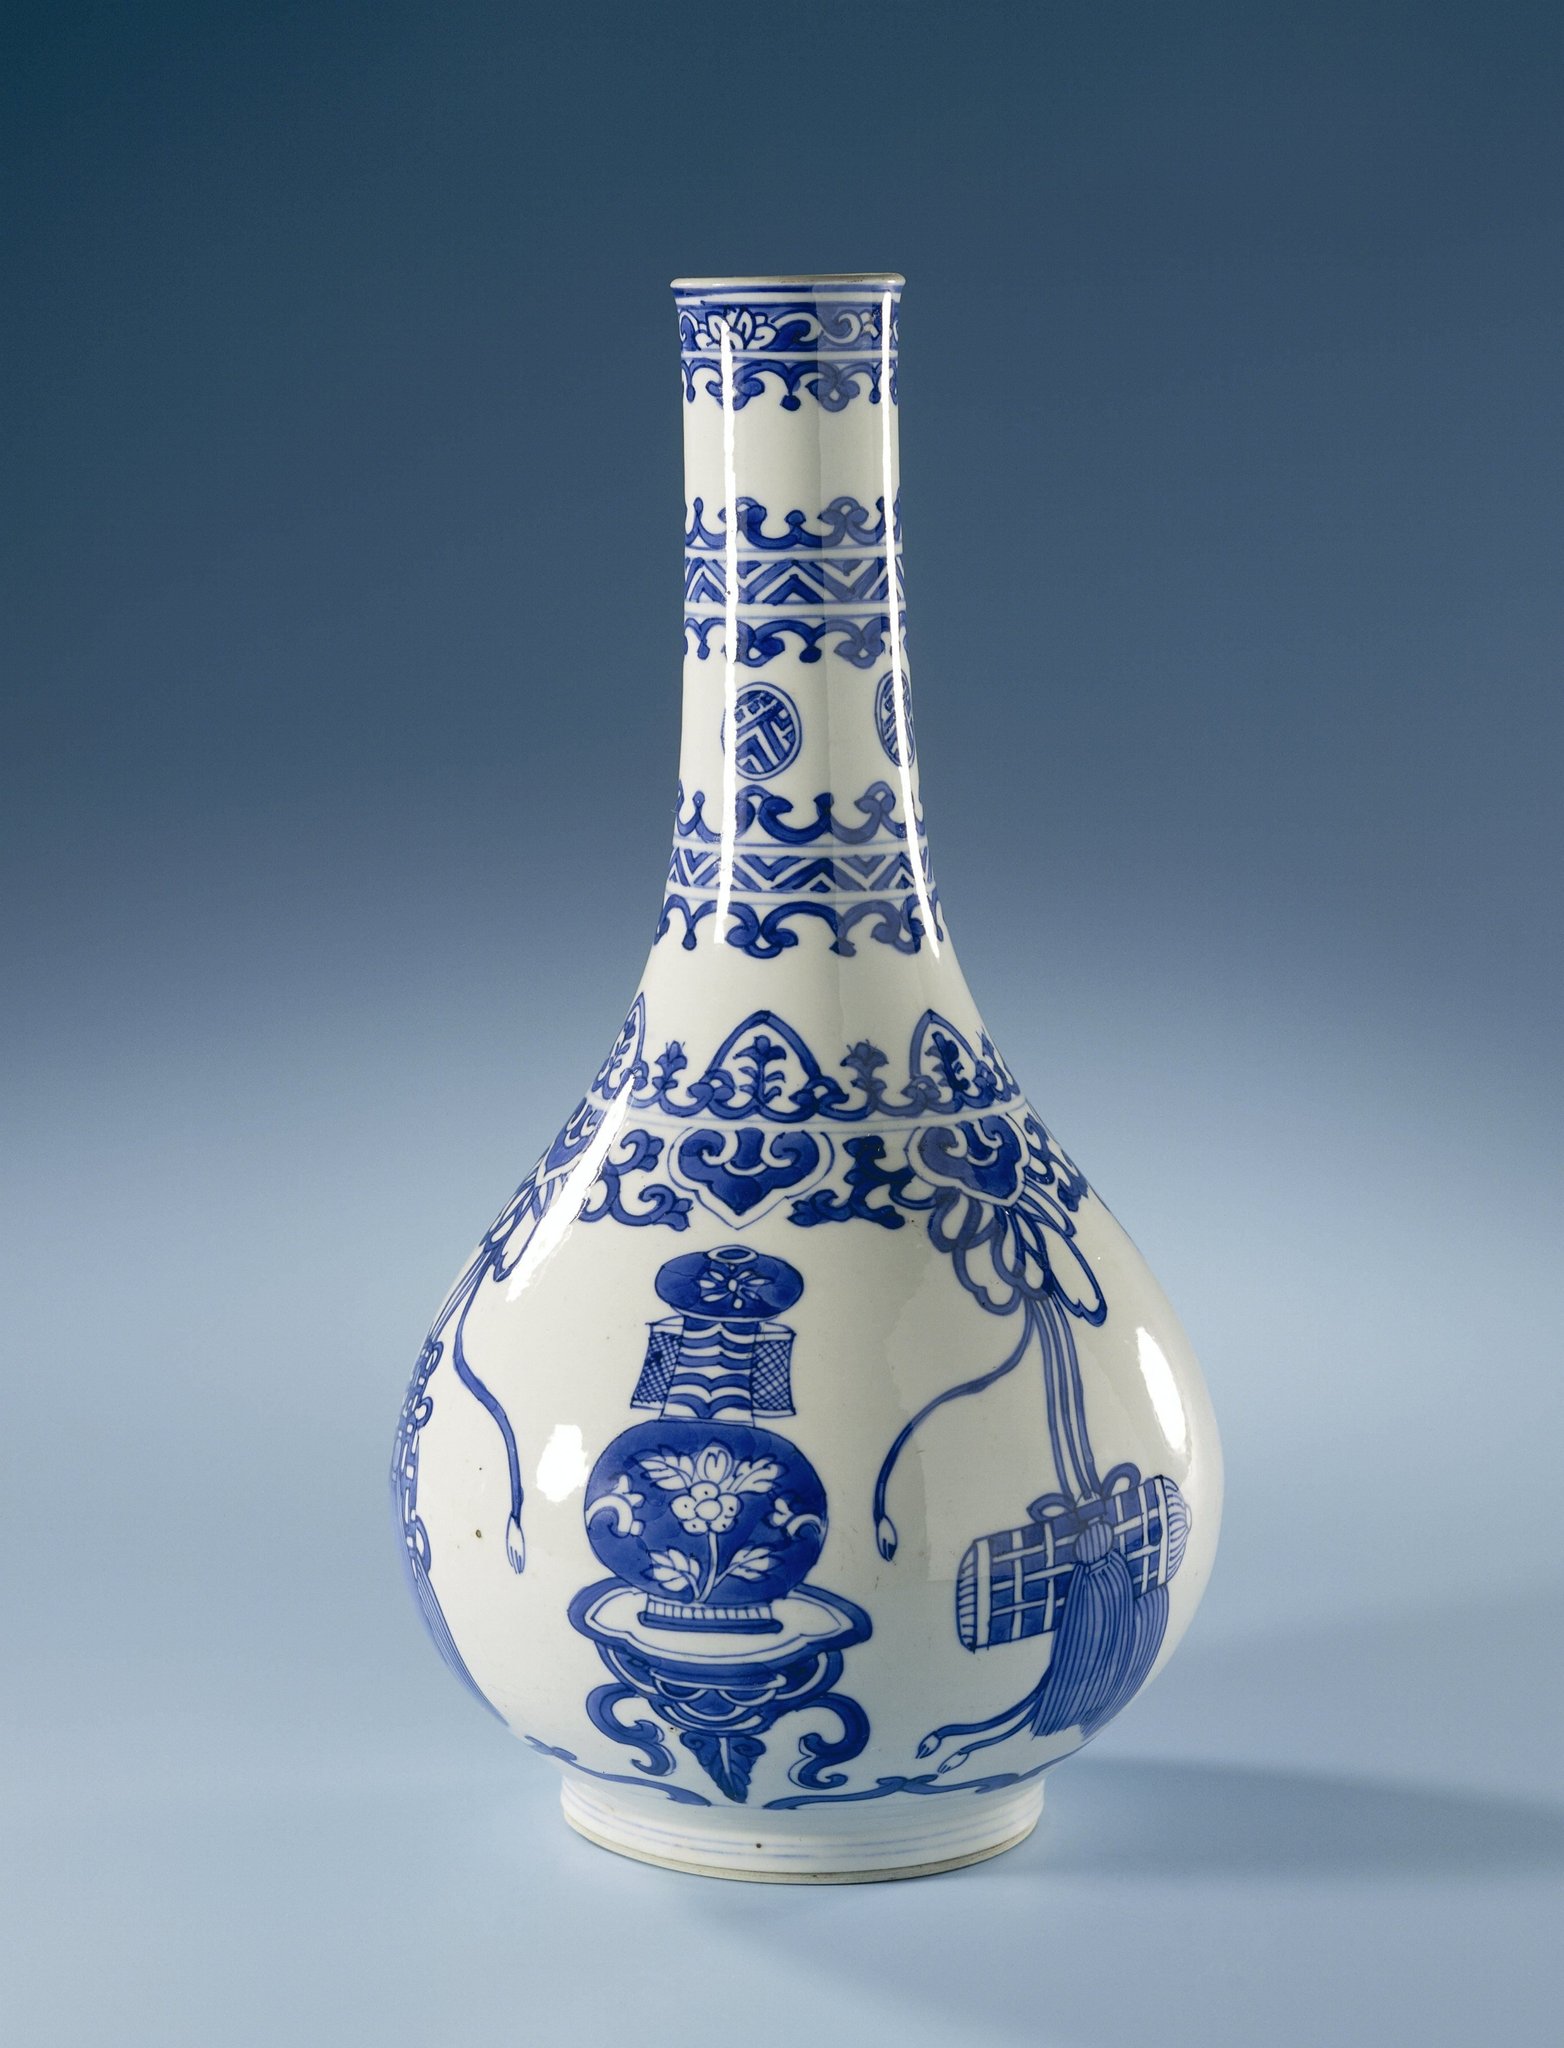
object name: bottle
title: Pear-shaped bottle vase with auspicious symbols, tassels and ornamental borders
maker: Anonymous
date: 1700-1724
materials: cobalt, glaze, paint, porcelain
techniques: firing, turning, vitrification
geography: china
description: Flesvormige vaas van porselein met peervormig lichaam en lange nek, beschilderd in onderglazuur blauw. Op de buik tweemaal een vaas op een lage tafel. Op de schouder een band met afhangende ruyi-motieven met ranken waaruit strikken op de buik hangen met daaraan kwasten en rollen. De nek met decoratieve banden en medaillons met geometrische motieven. Op de rand een band met bloemranken. Een barst in de nek. Blauw-wit.